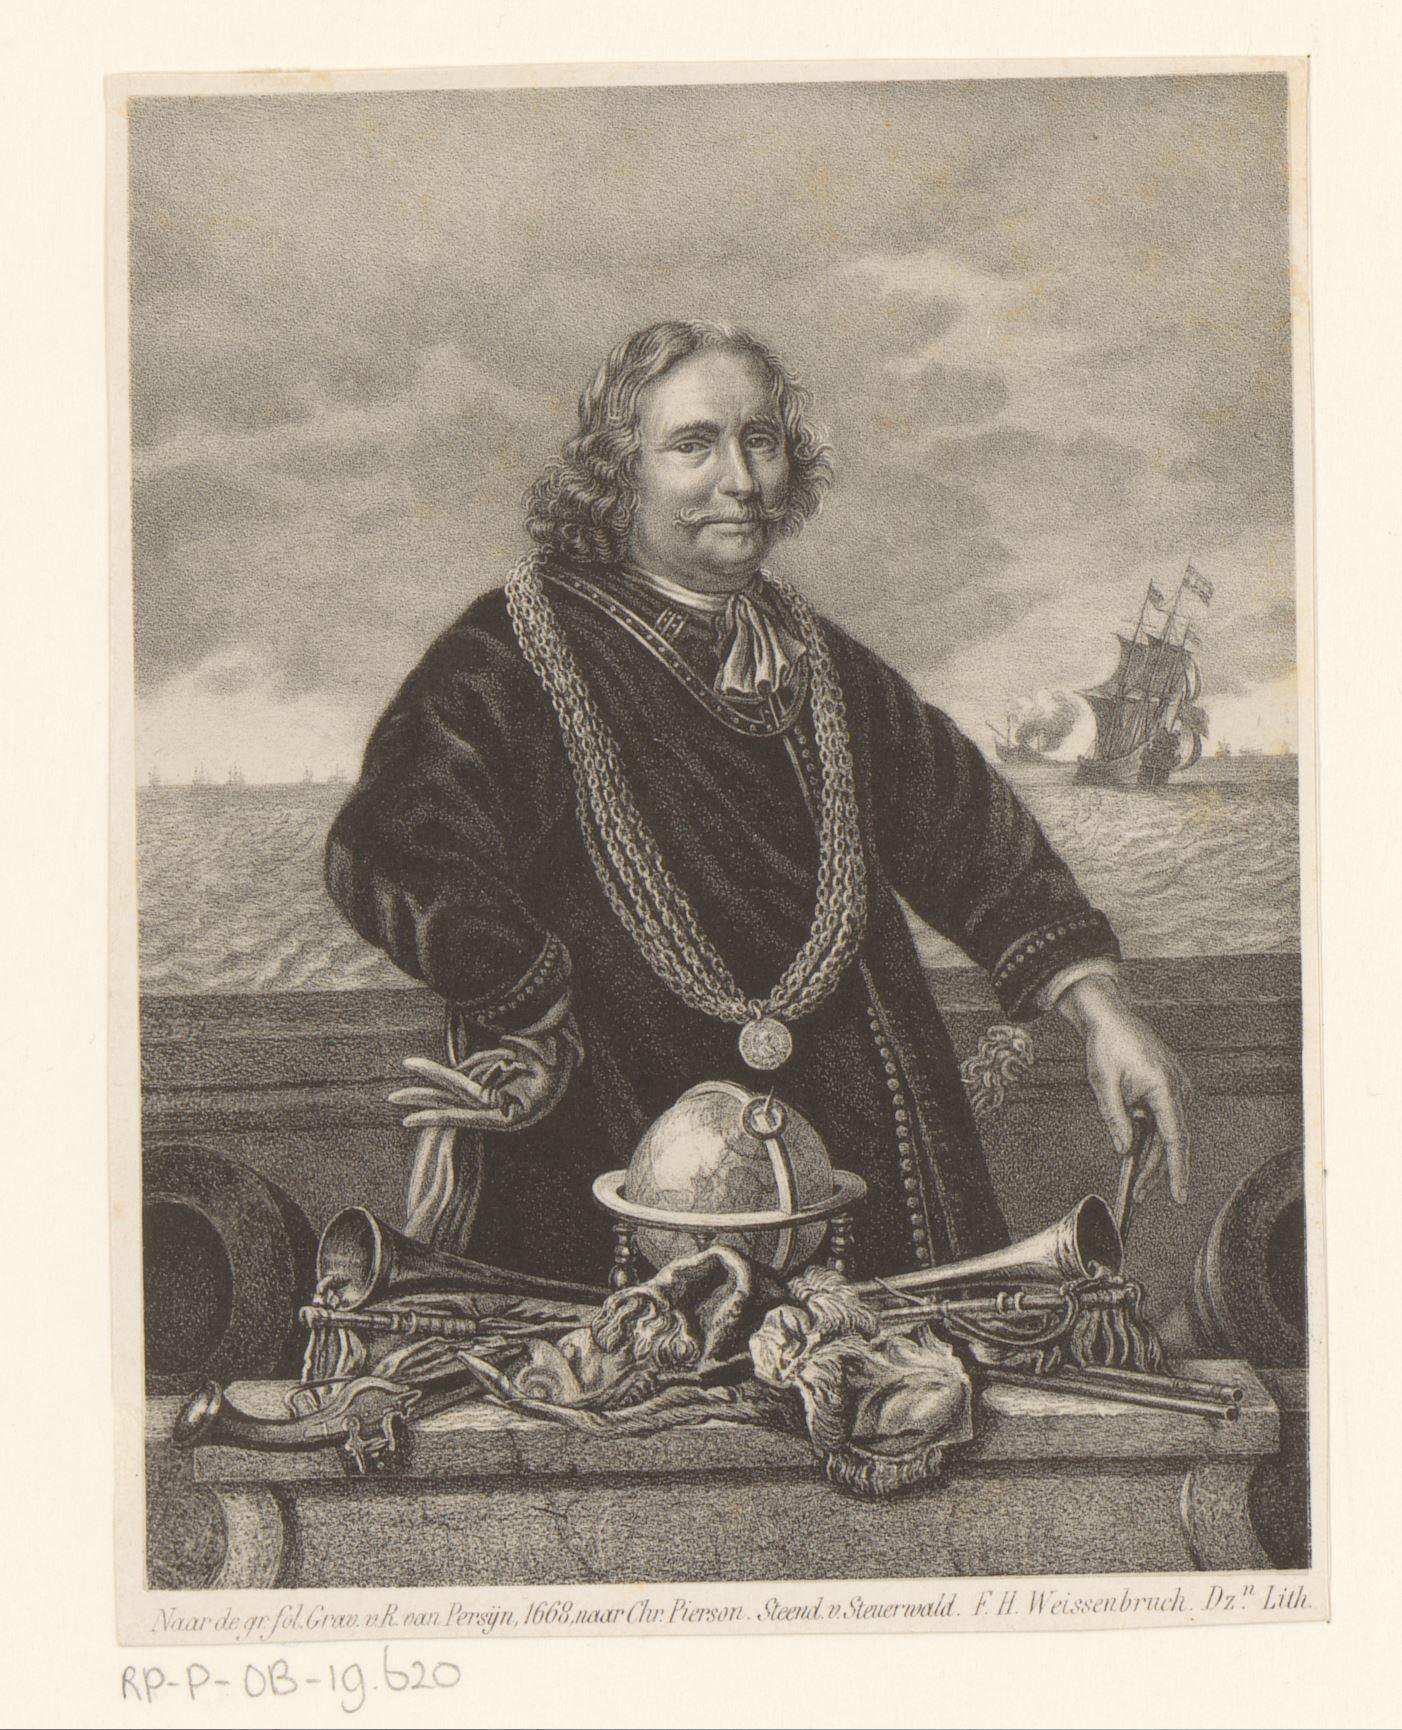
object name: book illustration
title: Portret van Jan Corneliszoon Meppel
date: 1858-1862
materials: paper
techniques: lithograph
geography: the hague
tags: hoorn (north holland), jan corneliszoon meppel, historical persons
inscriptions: collector's mark: Lugt 2228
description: Prent uit: Jonge, J.C. de. Geschiedenis van het Nederlandsche zeewezen. Haarlem: Jonge, J.K.J. de, 1858-62.